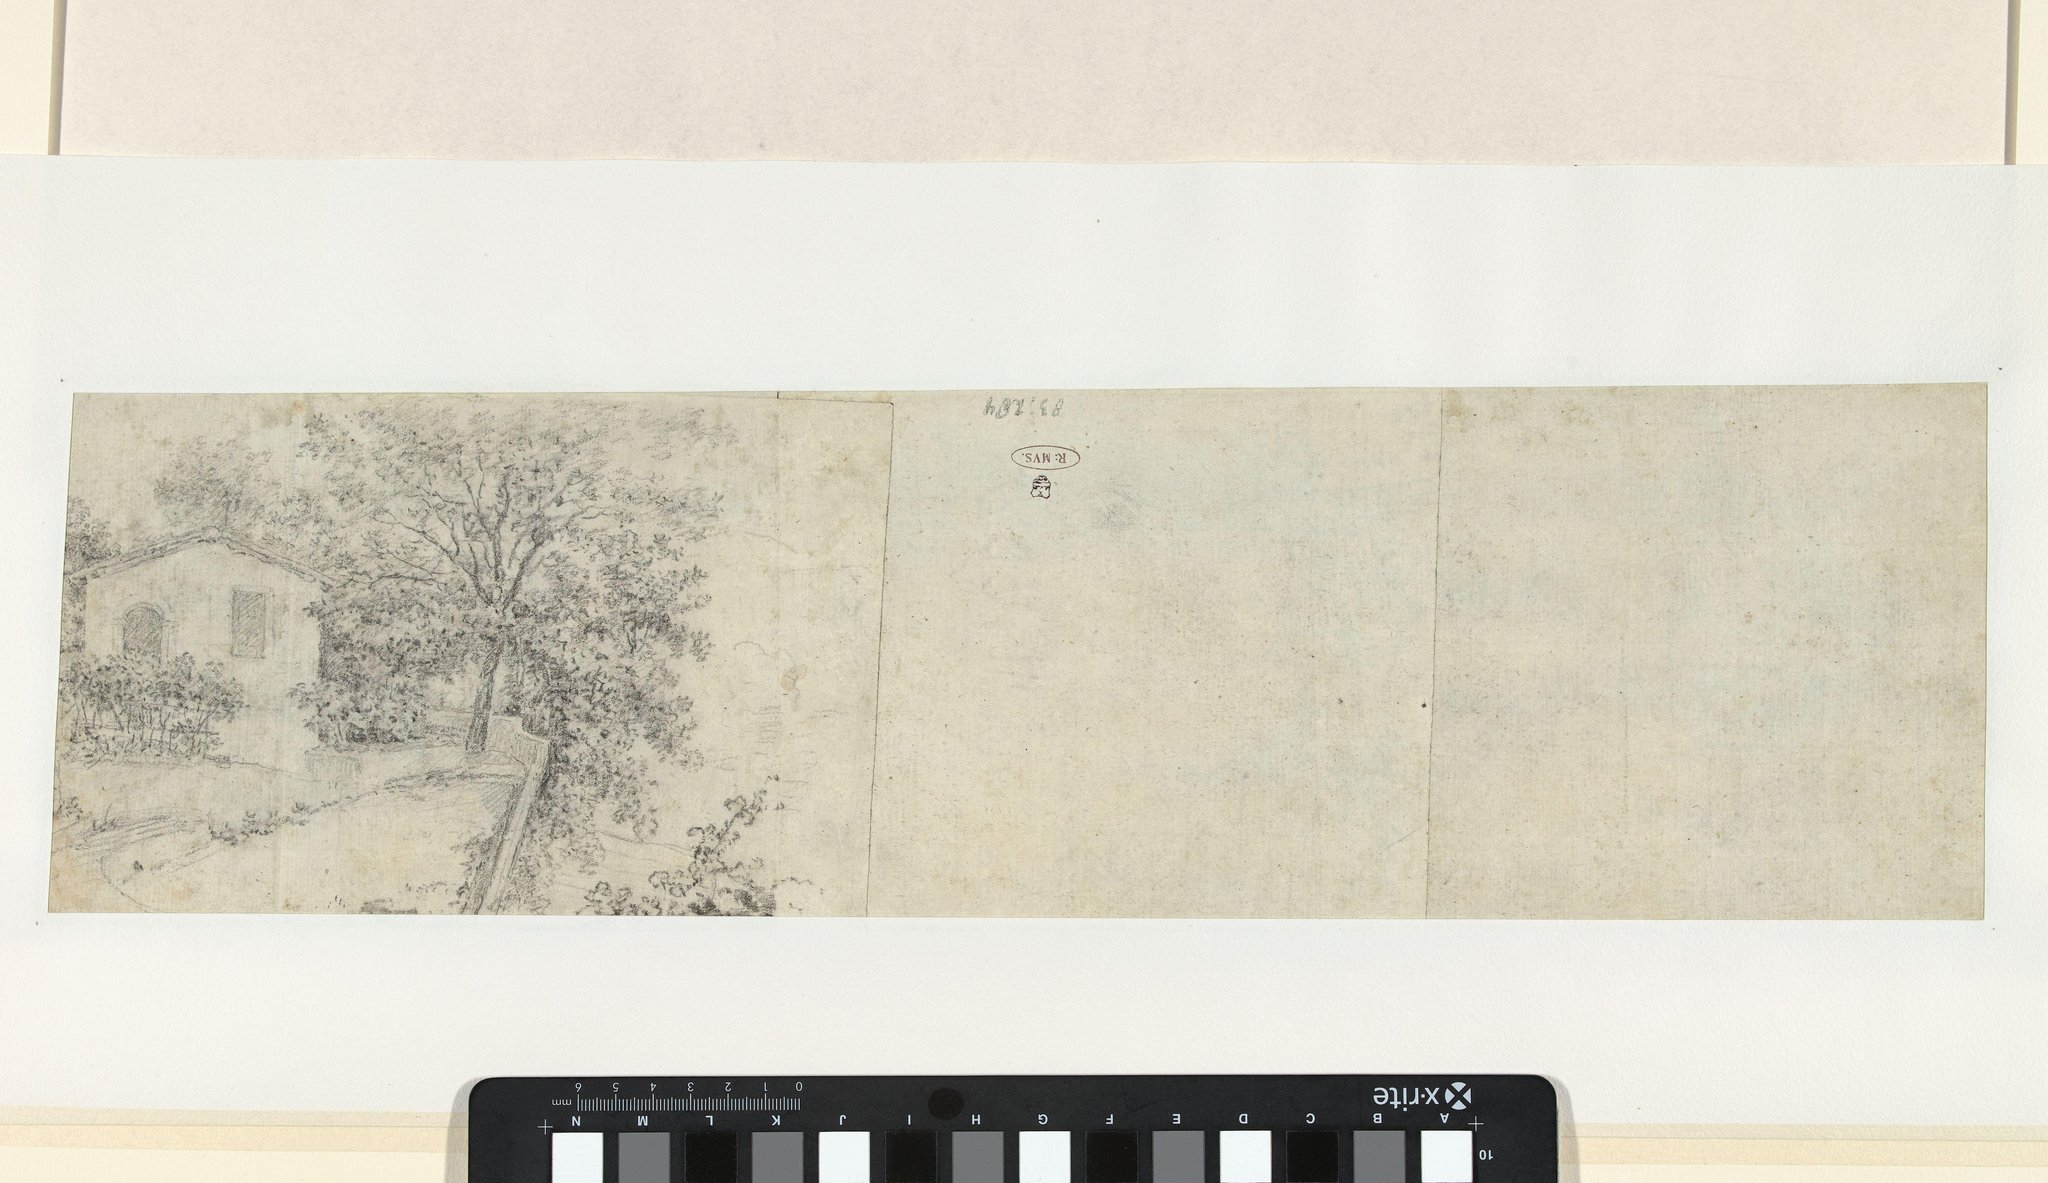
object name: drawing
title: Paviljoen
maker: pierre adrien pâris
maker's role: draughtsman, print maker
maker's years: 1745-1819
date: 1755-1819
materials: chalk, paper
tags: garden buildings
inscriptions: collector's mark: Lugt 2760, collector's mark: Lugt 2228a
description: Een van de paviljoens van RP-T-1963-284(R), gezien van een andere zijde.